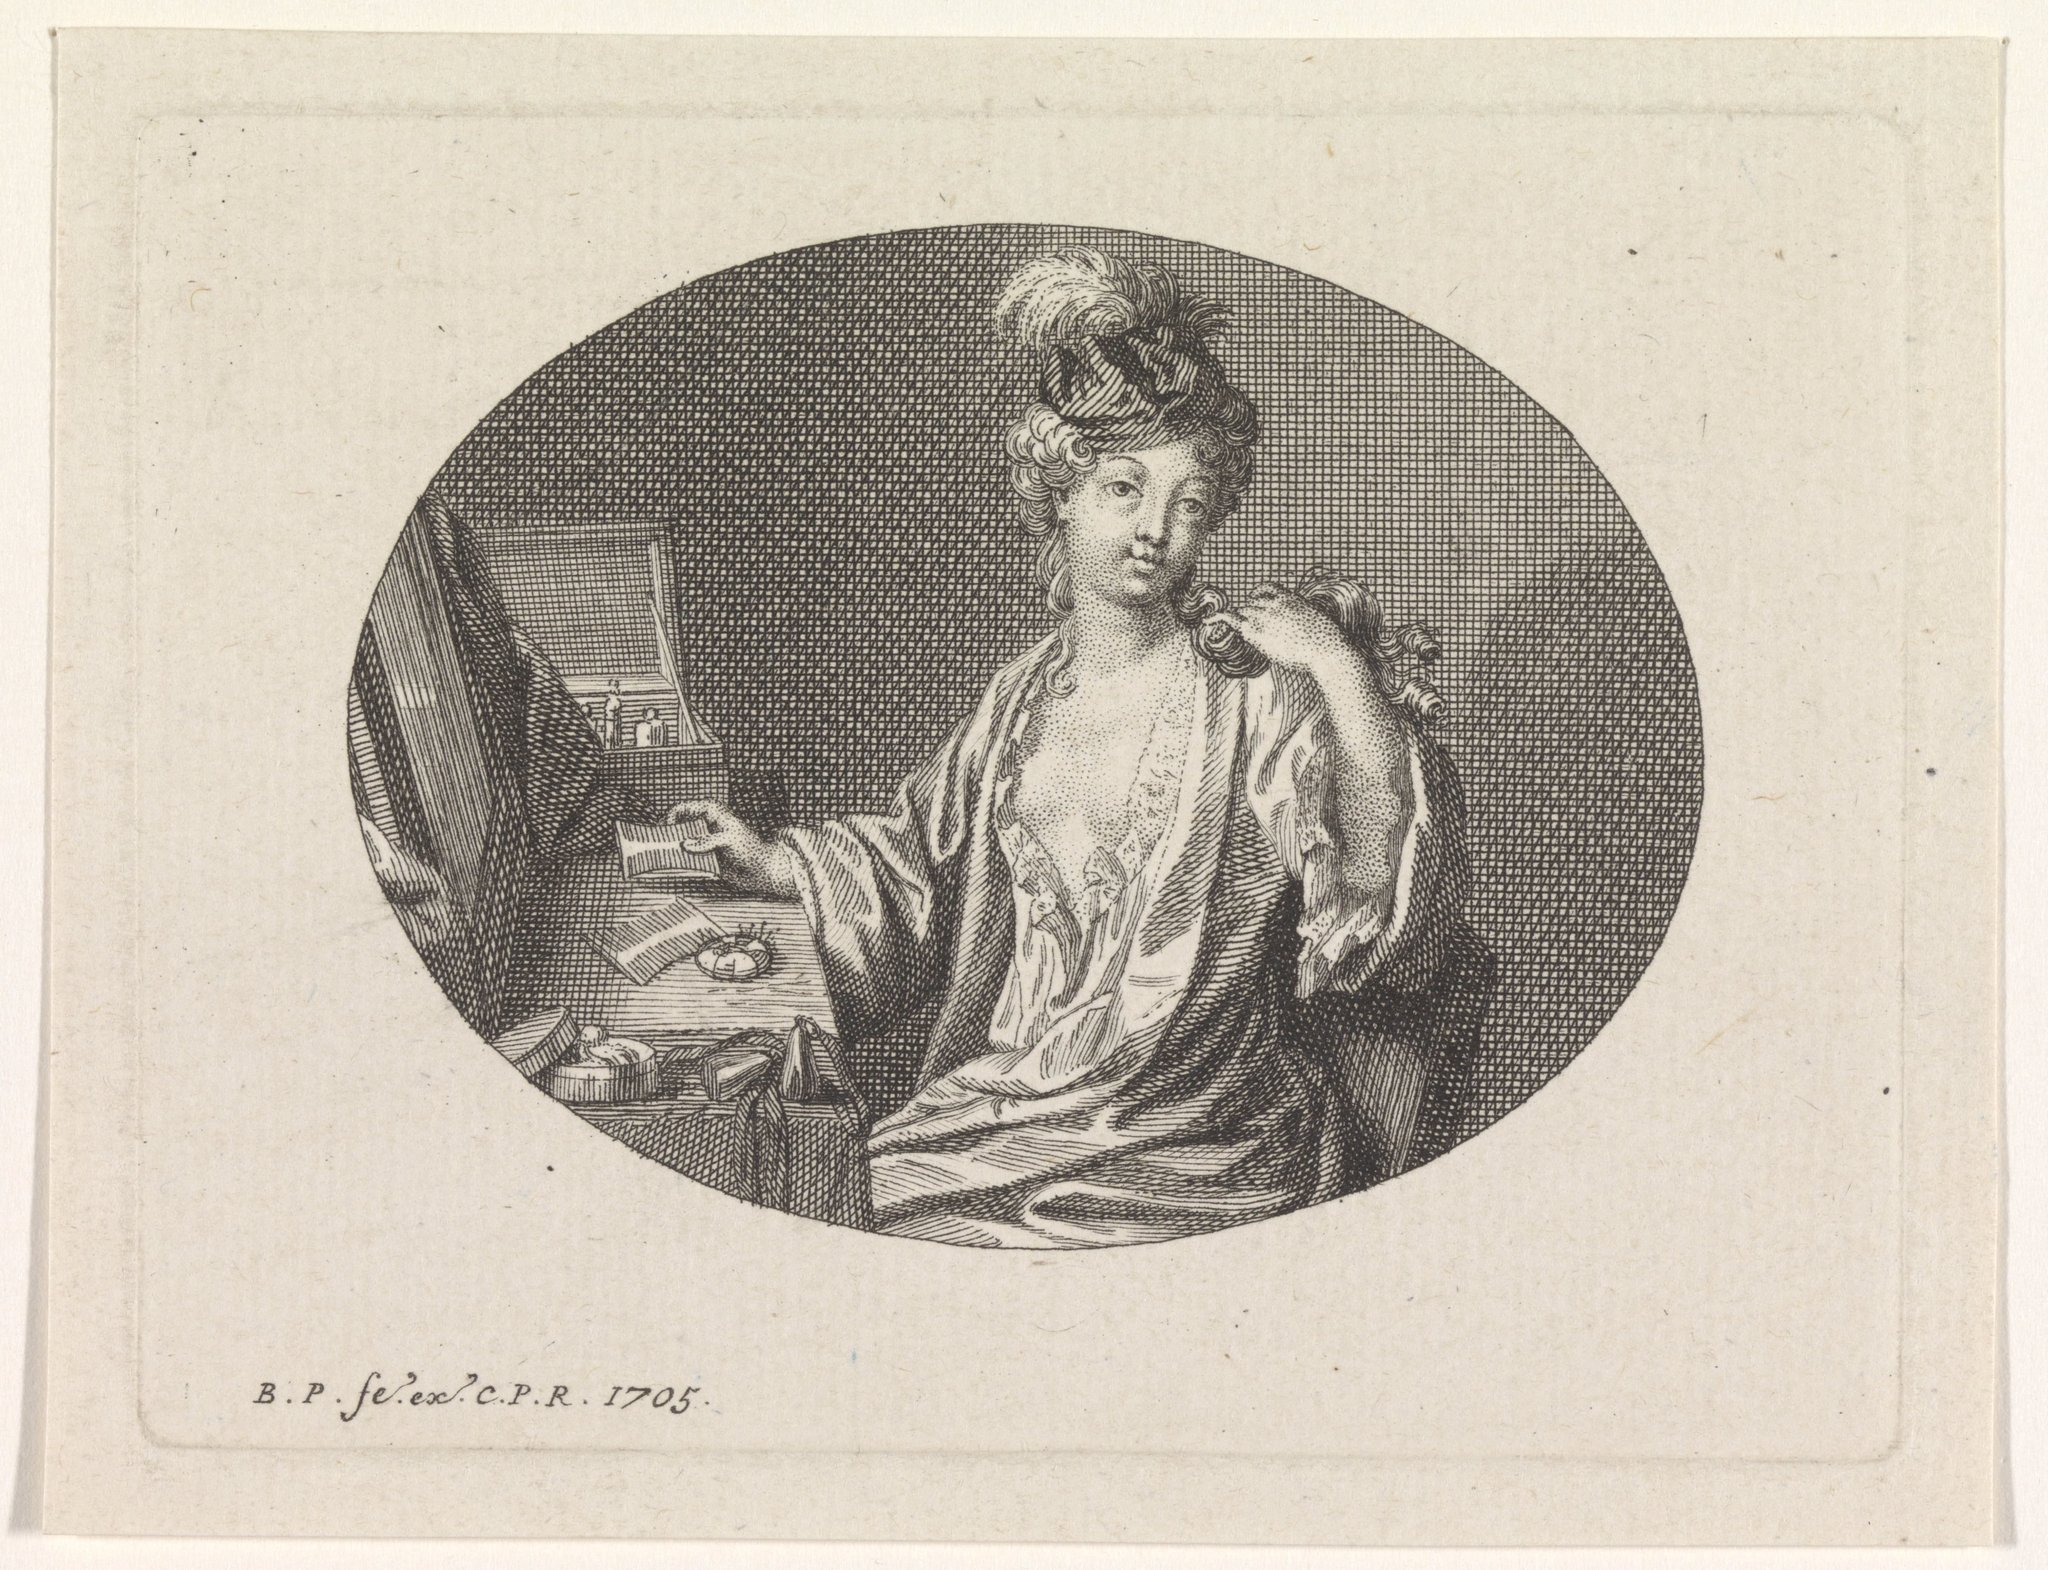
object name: print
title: Vrouw aan haar toilet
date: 1705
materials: paper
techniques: engraving, etching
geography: paris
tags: whore, prostitute, making toilet - aa - (for) women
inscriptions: collector's mark: Lugt 2228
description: Een vrouw zit aan haar toilettafel waarop een spiegel en poederdozen. In haar hand houdt ze een kam. Zij draagt een jurk die haar borsten vrijwel onbedekt laat.